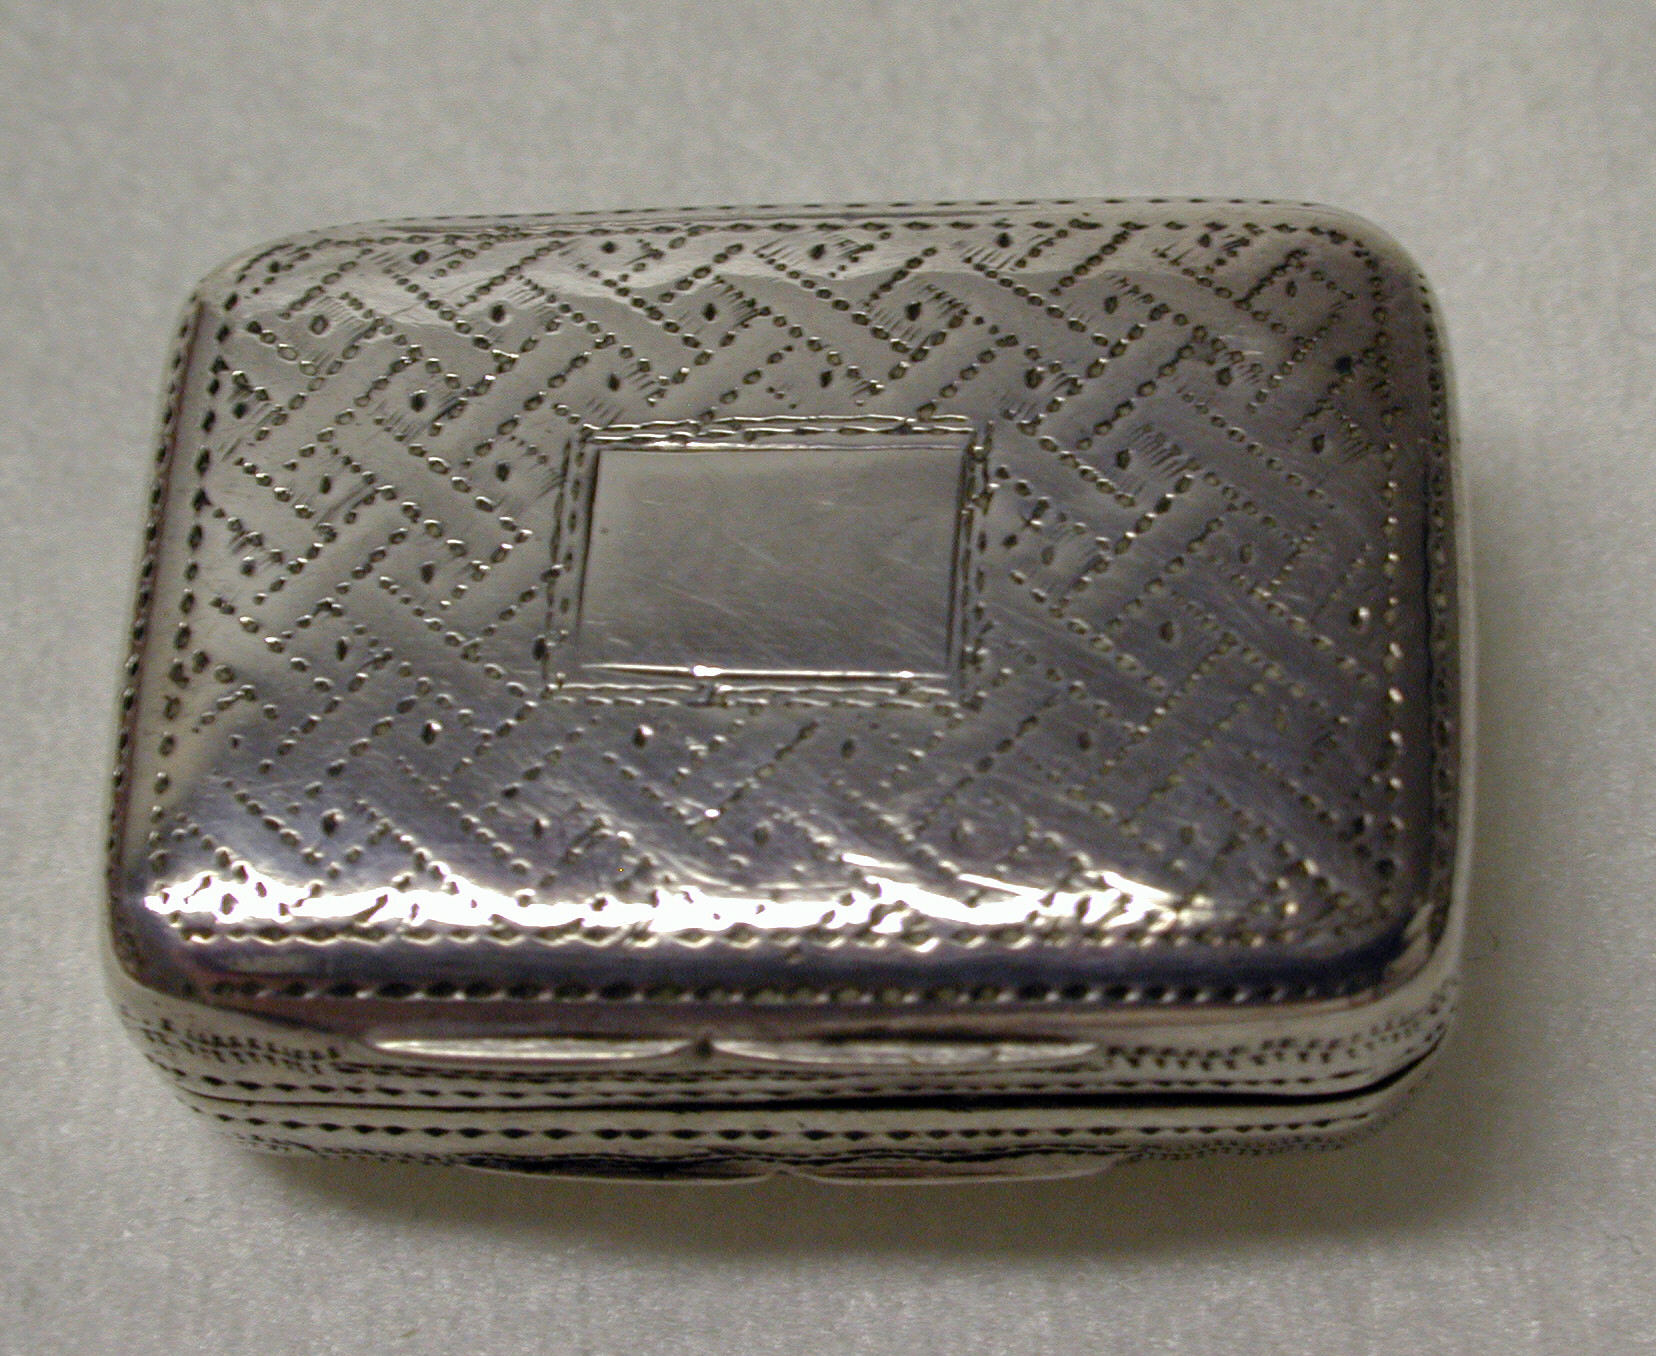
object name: vinaigrette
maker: thomas shaw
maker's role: maker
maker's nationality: british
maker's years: 1818-1845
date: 1823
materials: silver